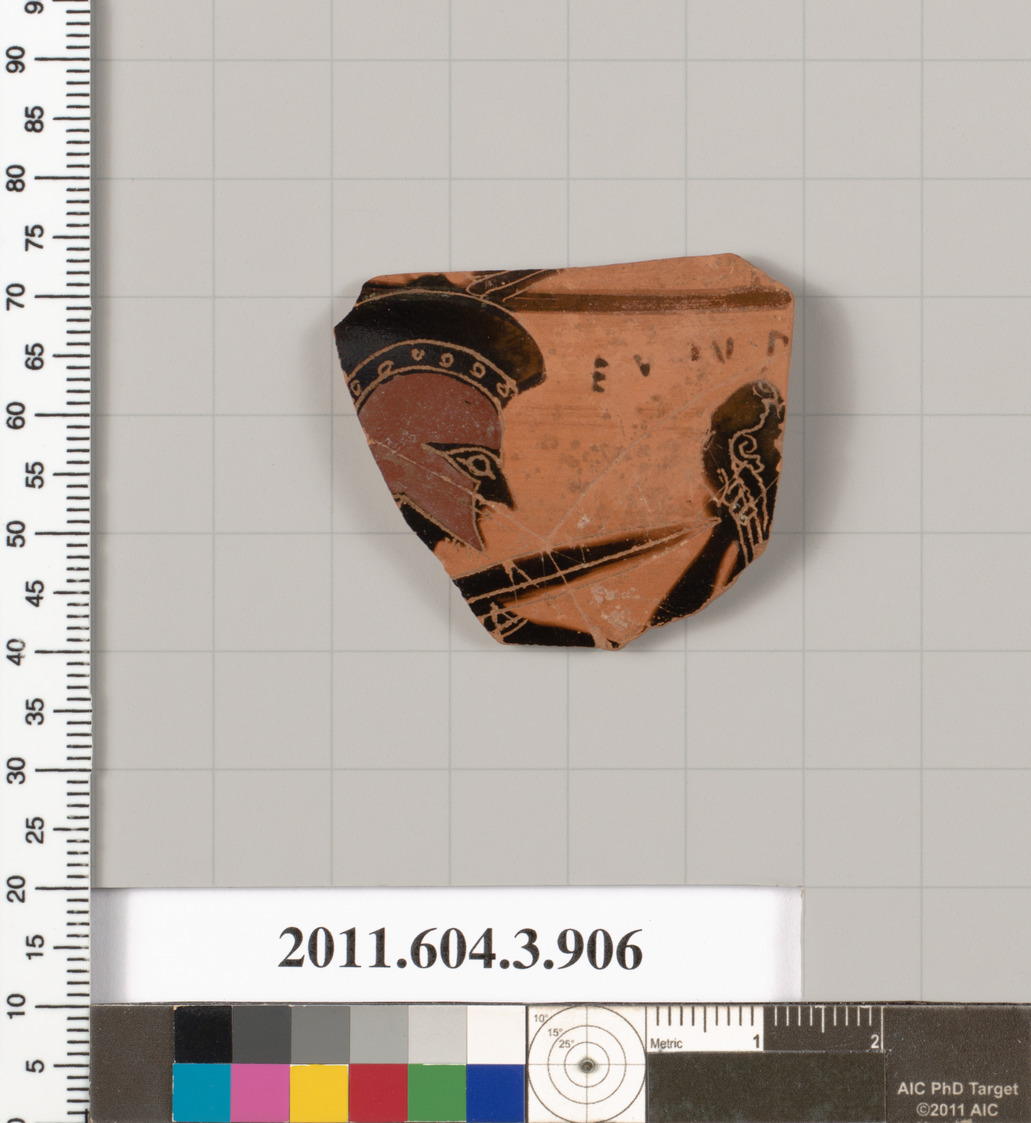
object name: lekythos fragment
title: Terracotta fragment of a lekythos (oil flask)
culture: greek, attic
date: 550-526 BCE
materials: terracotta